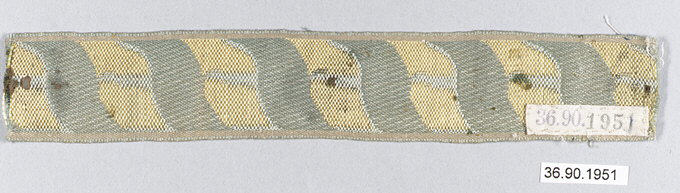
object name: galloon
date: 1801-1900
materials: silk